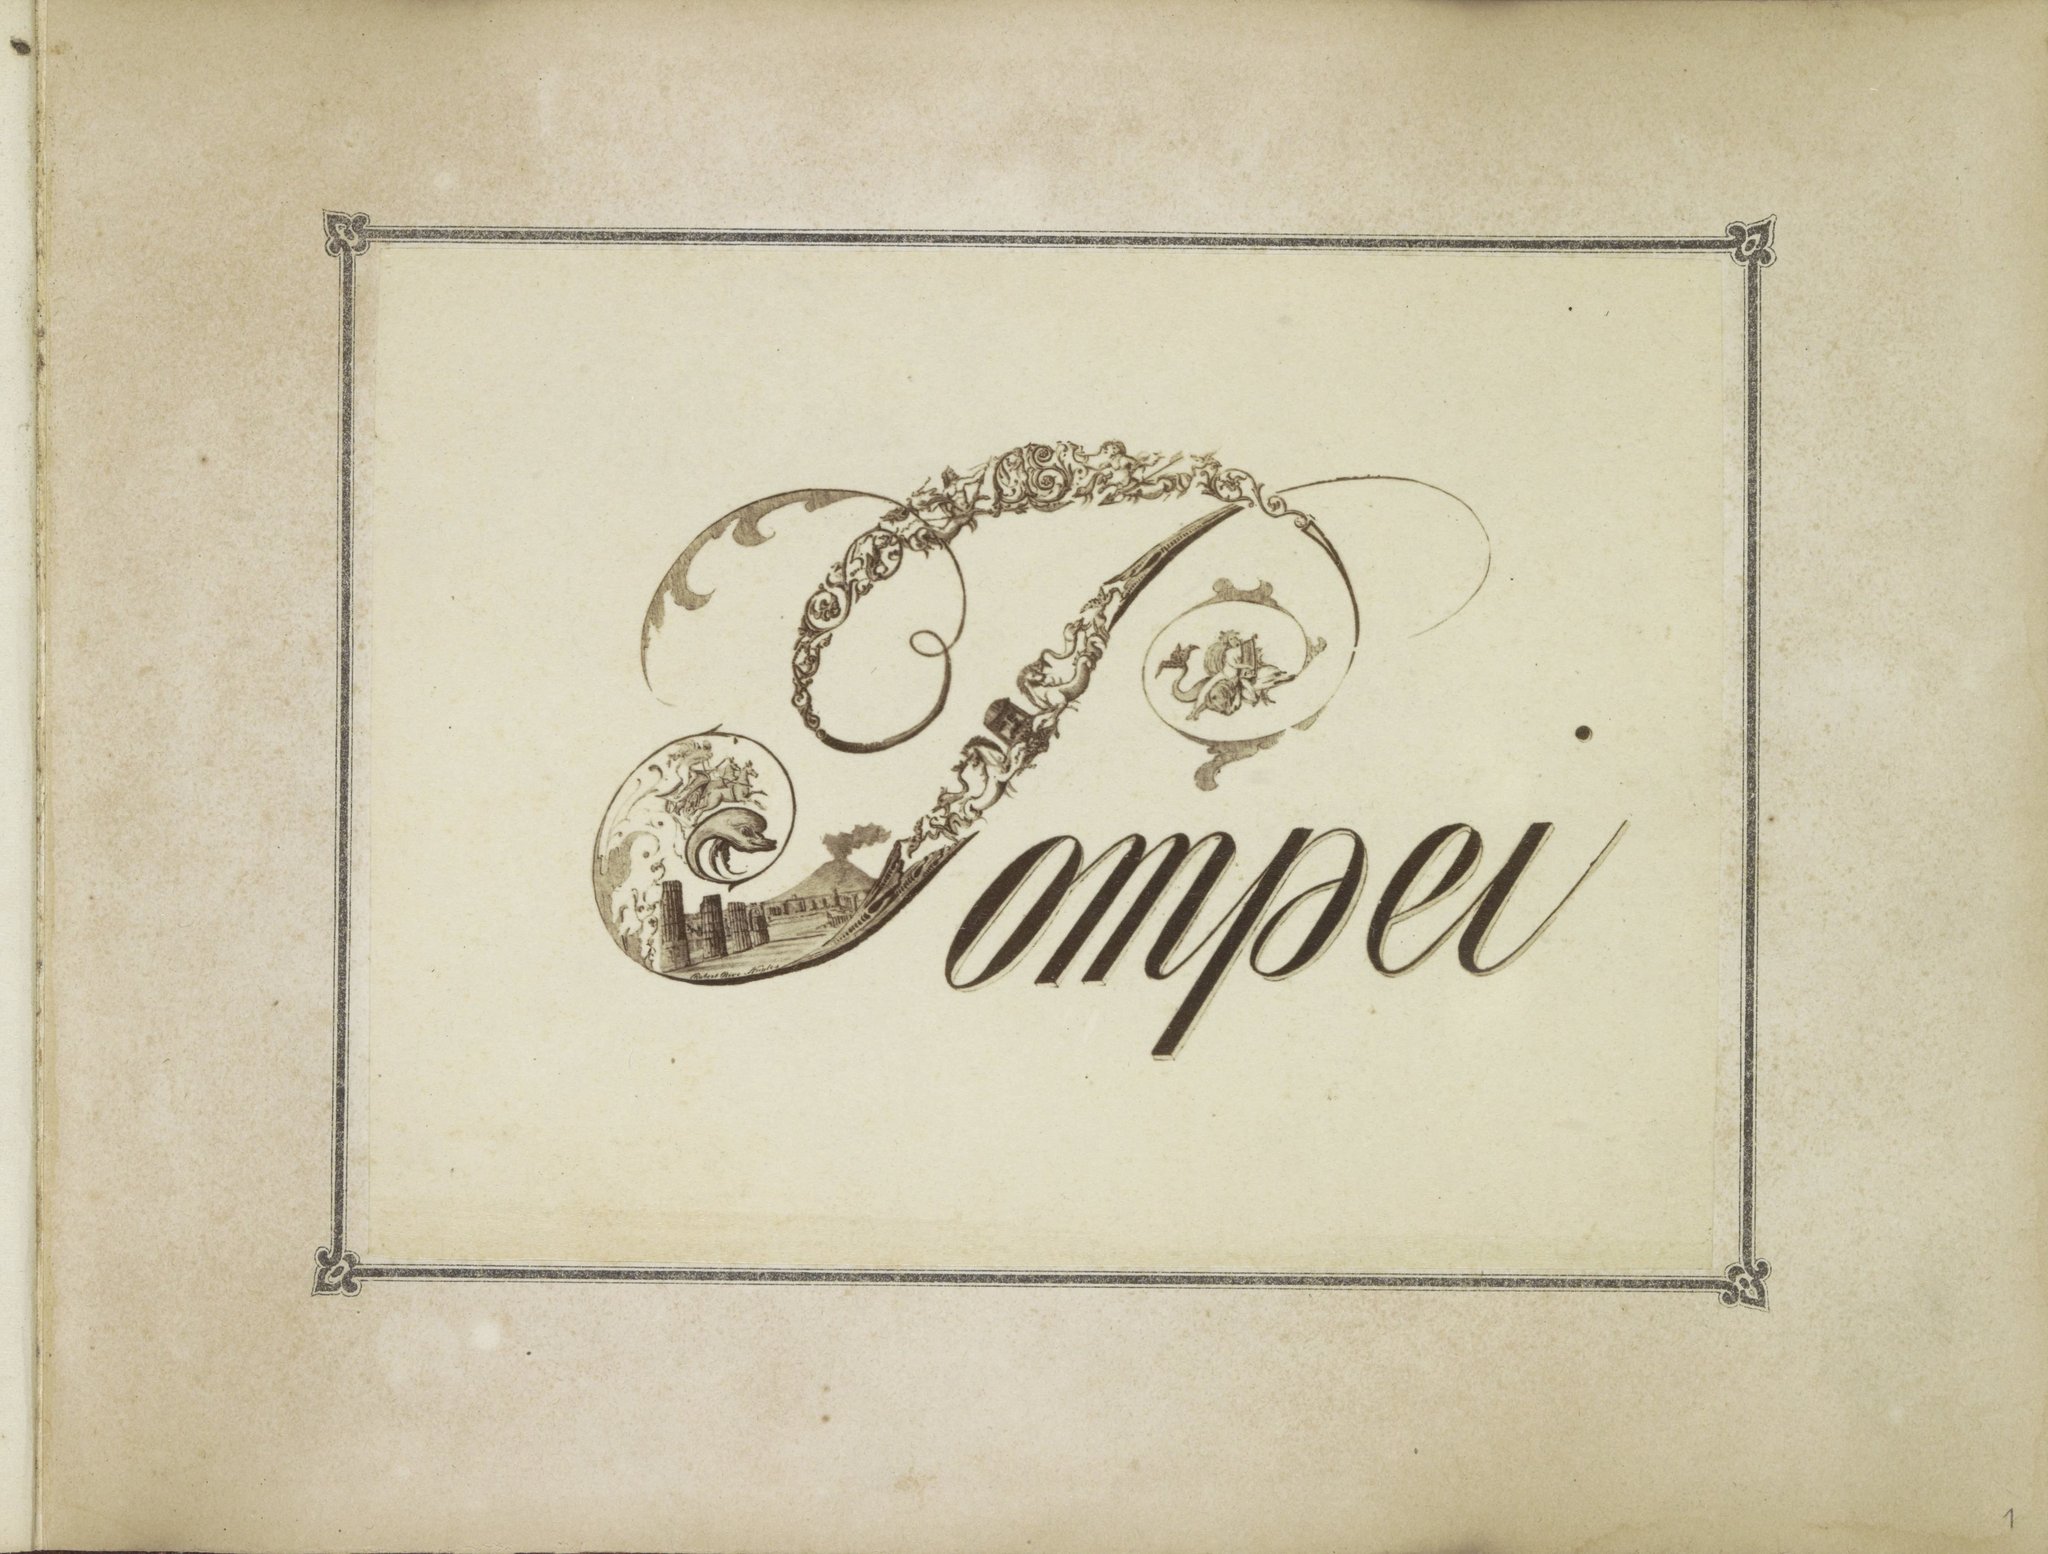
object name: reproduction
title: Fotoreproductie van (vermoedelijk) een prent met de titel van het fotoalbum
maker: roberto rive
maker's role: fotograaf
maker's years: 1825-1868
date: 1860-1900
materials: paper, photographic support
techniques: albumen print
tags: pompeii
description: Onderdeel van Fotoalbum met opnames van opgravingen in Pompeï door Roberto Rive.